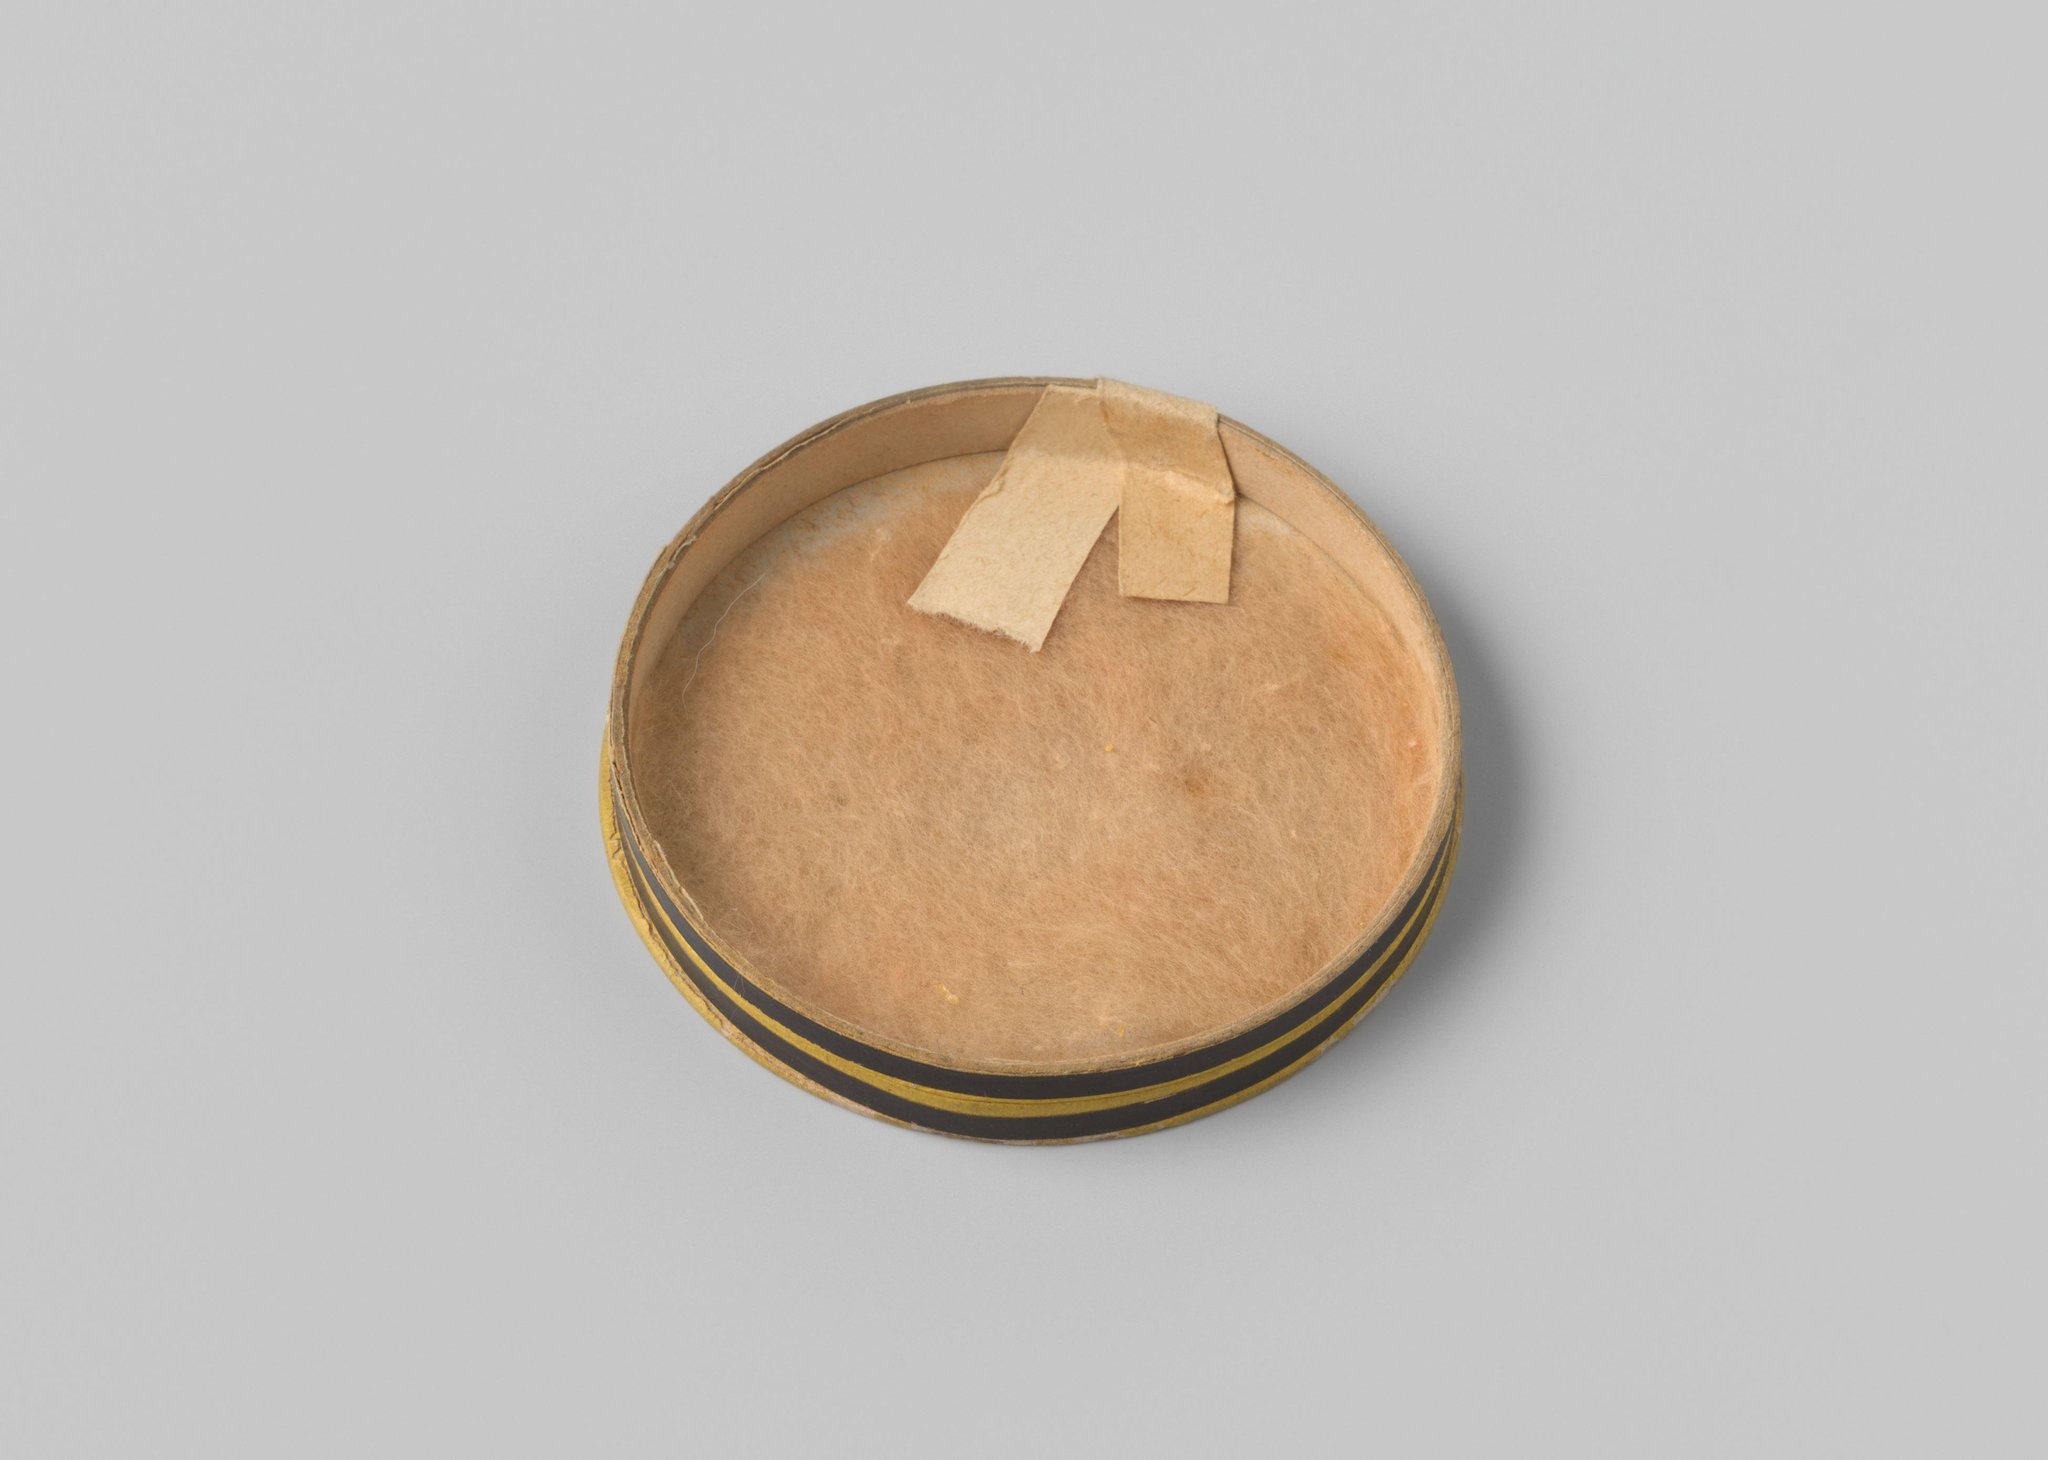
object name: box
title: Doos horend bij een bronzen penning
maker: francois ignace baetes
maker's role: sculptor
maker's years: 1826-1890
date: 1889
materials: cardboard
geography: antwerp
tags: antwerp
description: Rond kartonnen doosje, geel met twee zwarte strepen. De binnenzijde is gewatteerd, deksel ontbreekt.